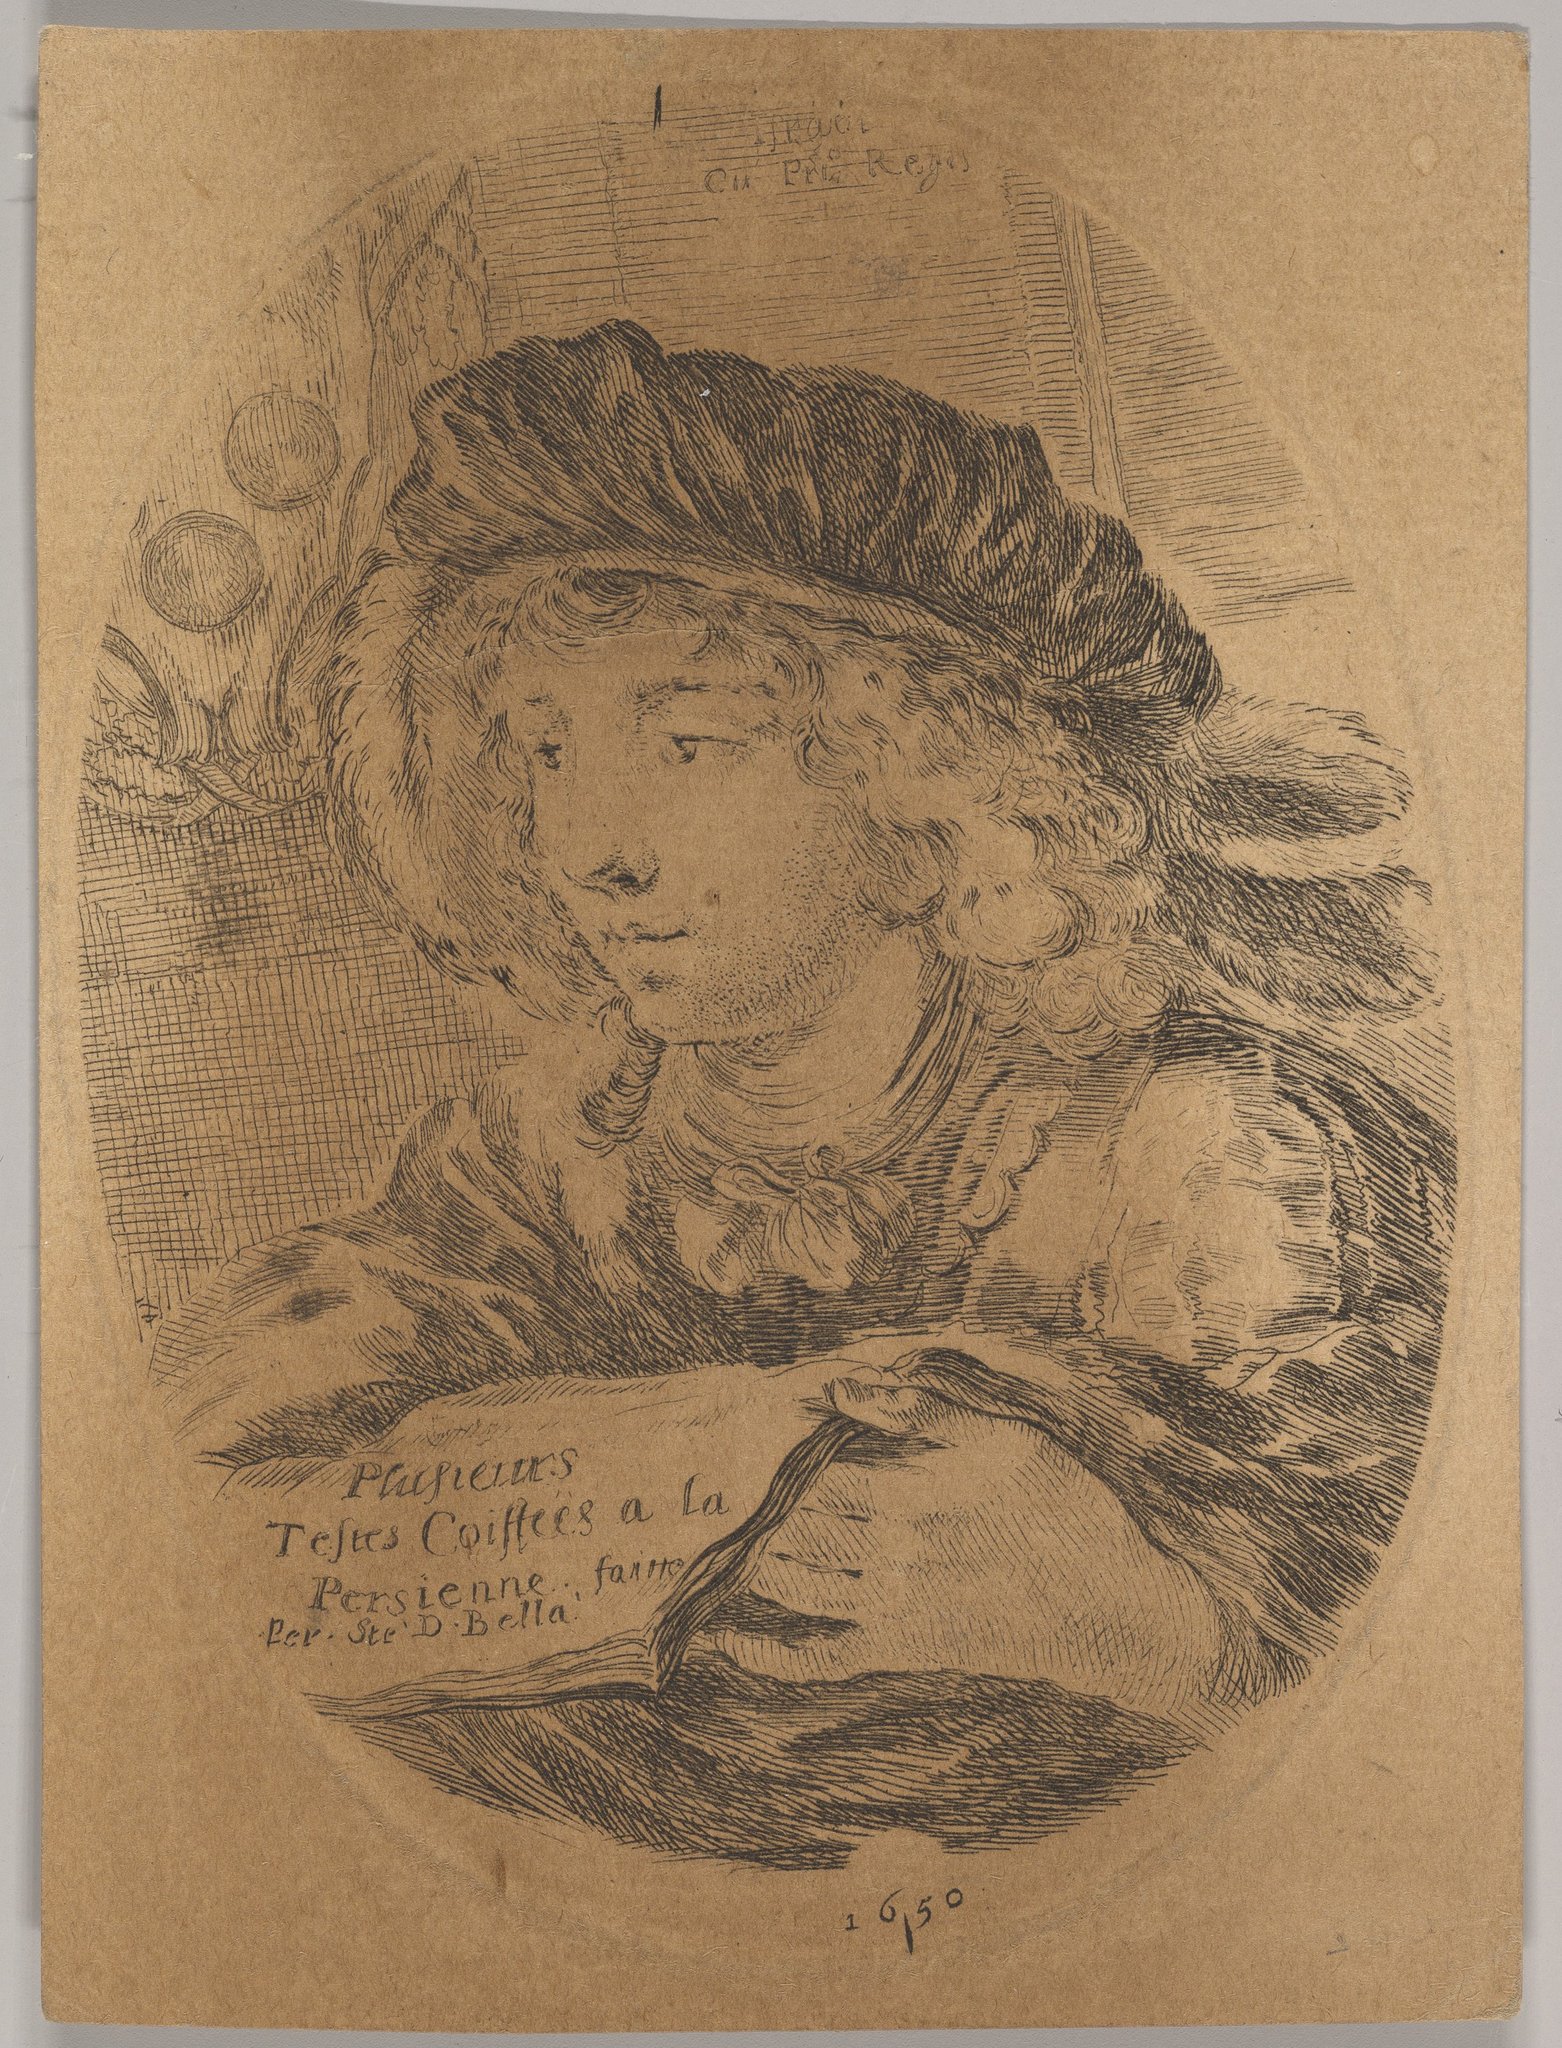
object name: print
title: A bust of a young man wearing a cap with feathers, turned three-quarters to the left, the coat of arms of the Grand Duke of Tuscany in top left, title page from "Several heads in the Persian style" (Plusieurs têtes coiffées à la persienne)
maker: stefano della bella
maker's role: artist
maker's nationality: italian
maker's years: 1610-1664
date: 1650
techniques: etching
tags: men,portraits